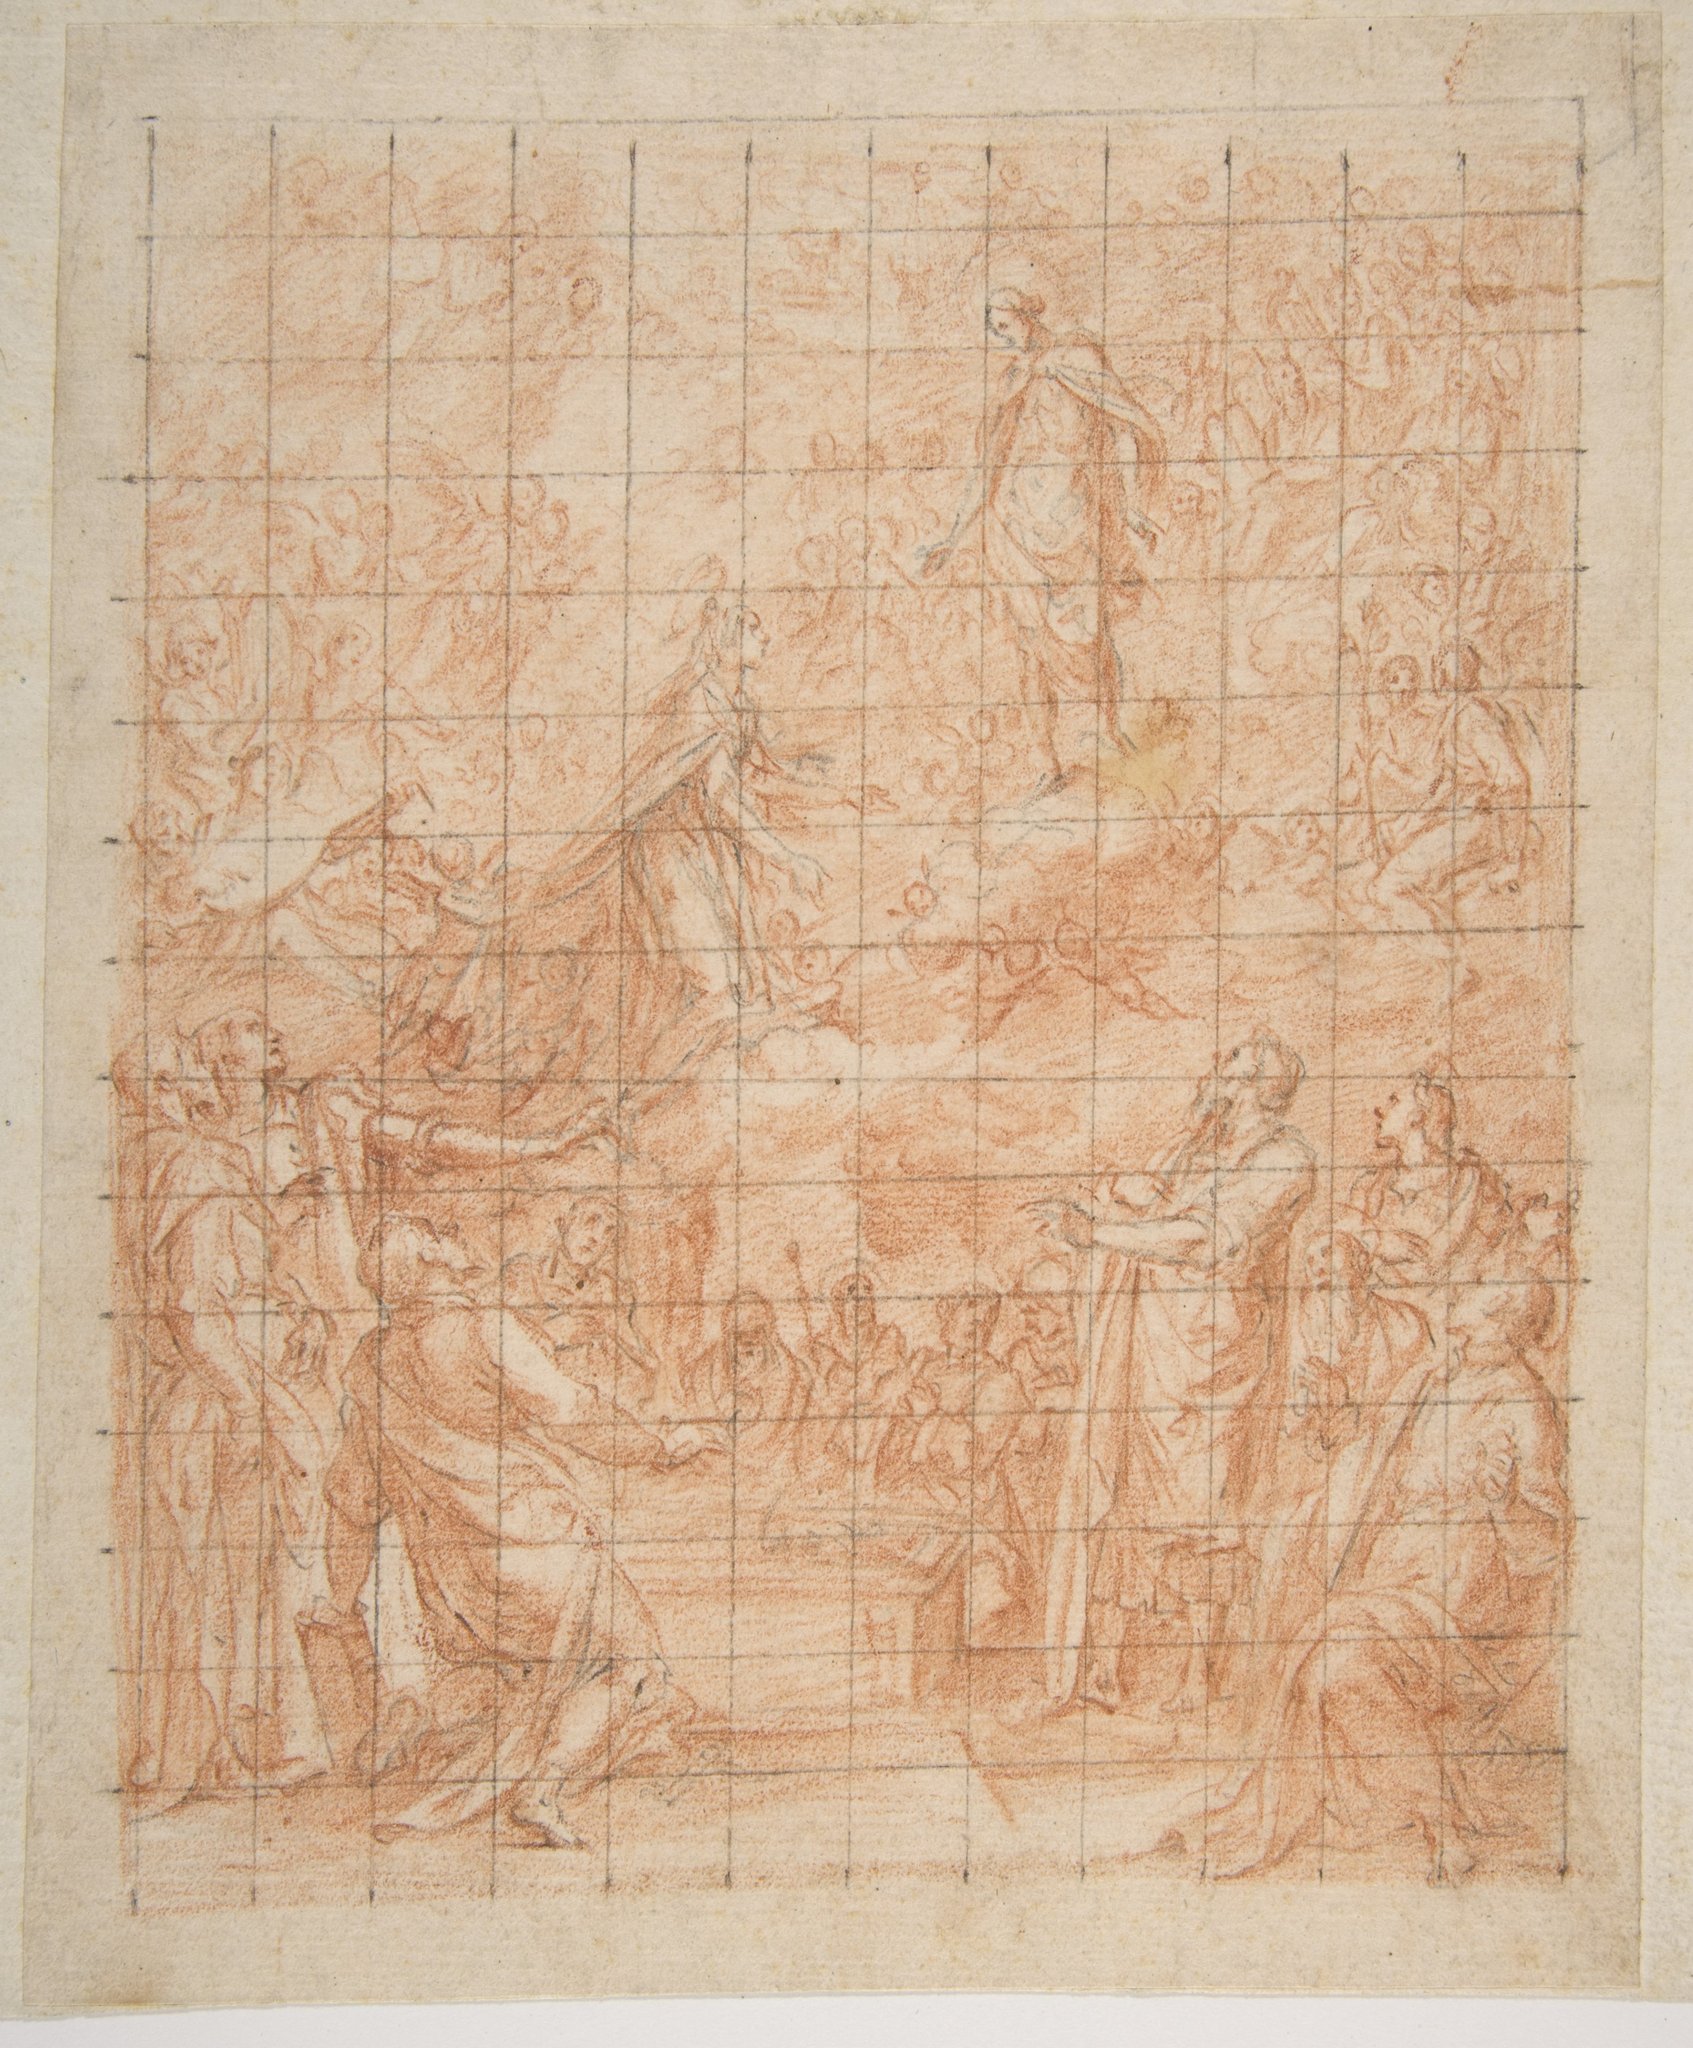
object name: drawing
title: The Assumption of the Virgin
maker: bernardino poccetti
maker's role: artist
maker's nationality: italian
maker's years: 1548-1612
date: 1548-1612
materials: chalk, charcoal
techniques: drawing, transfer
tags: virgin mary,assumption of the virgin